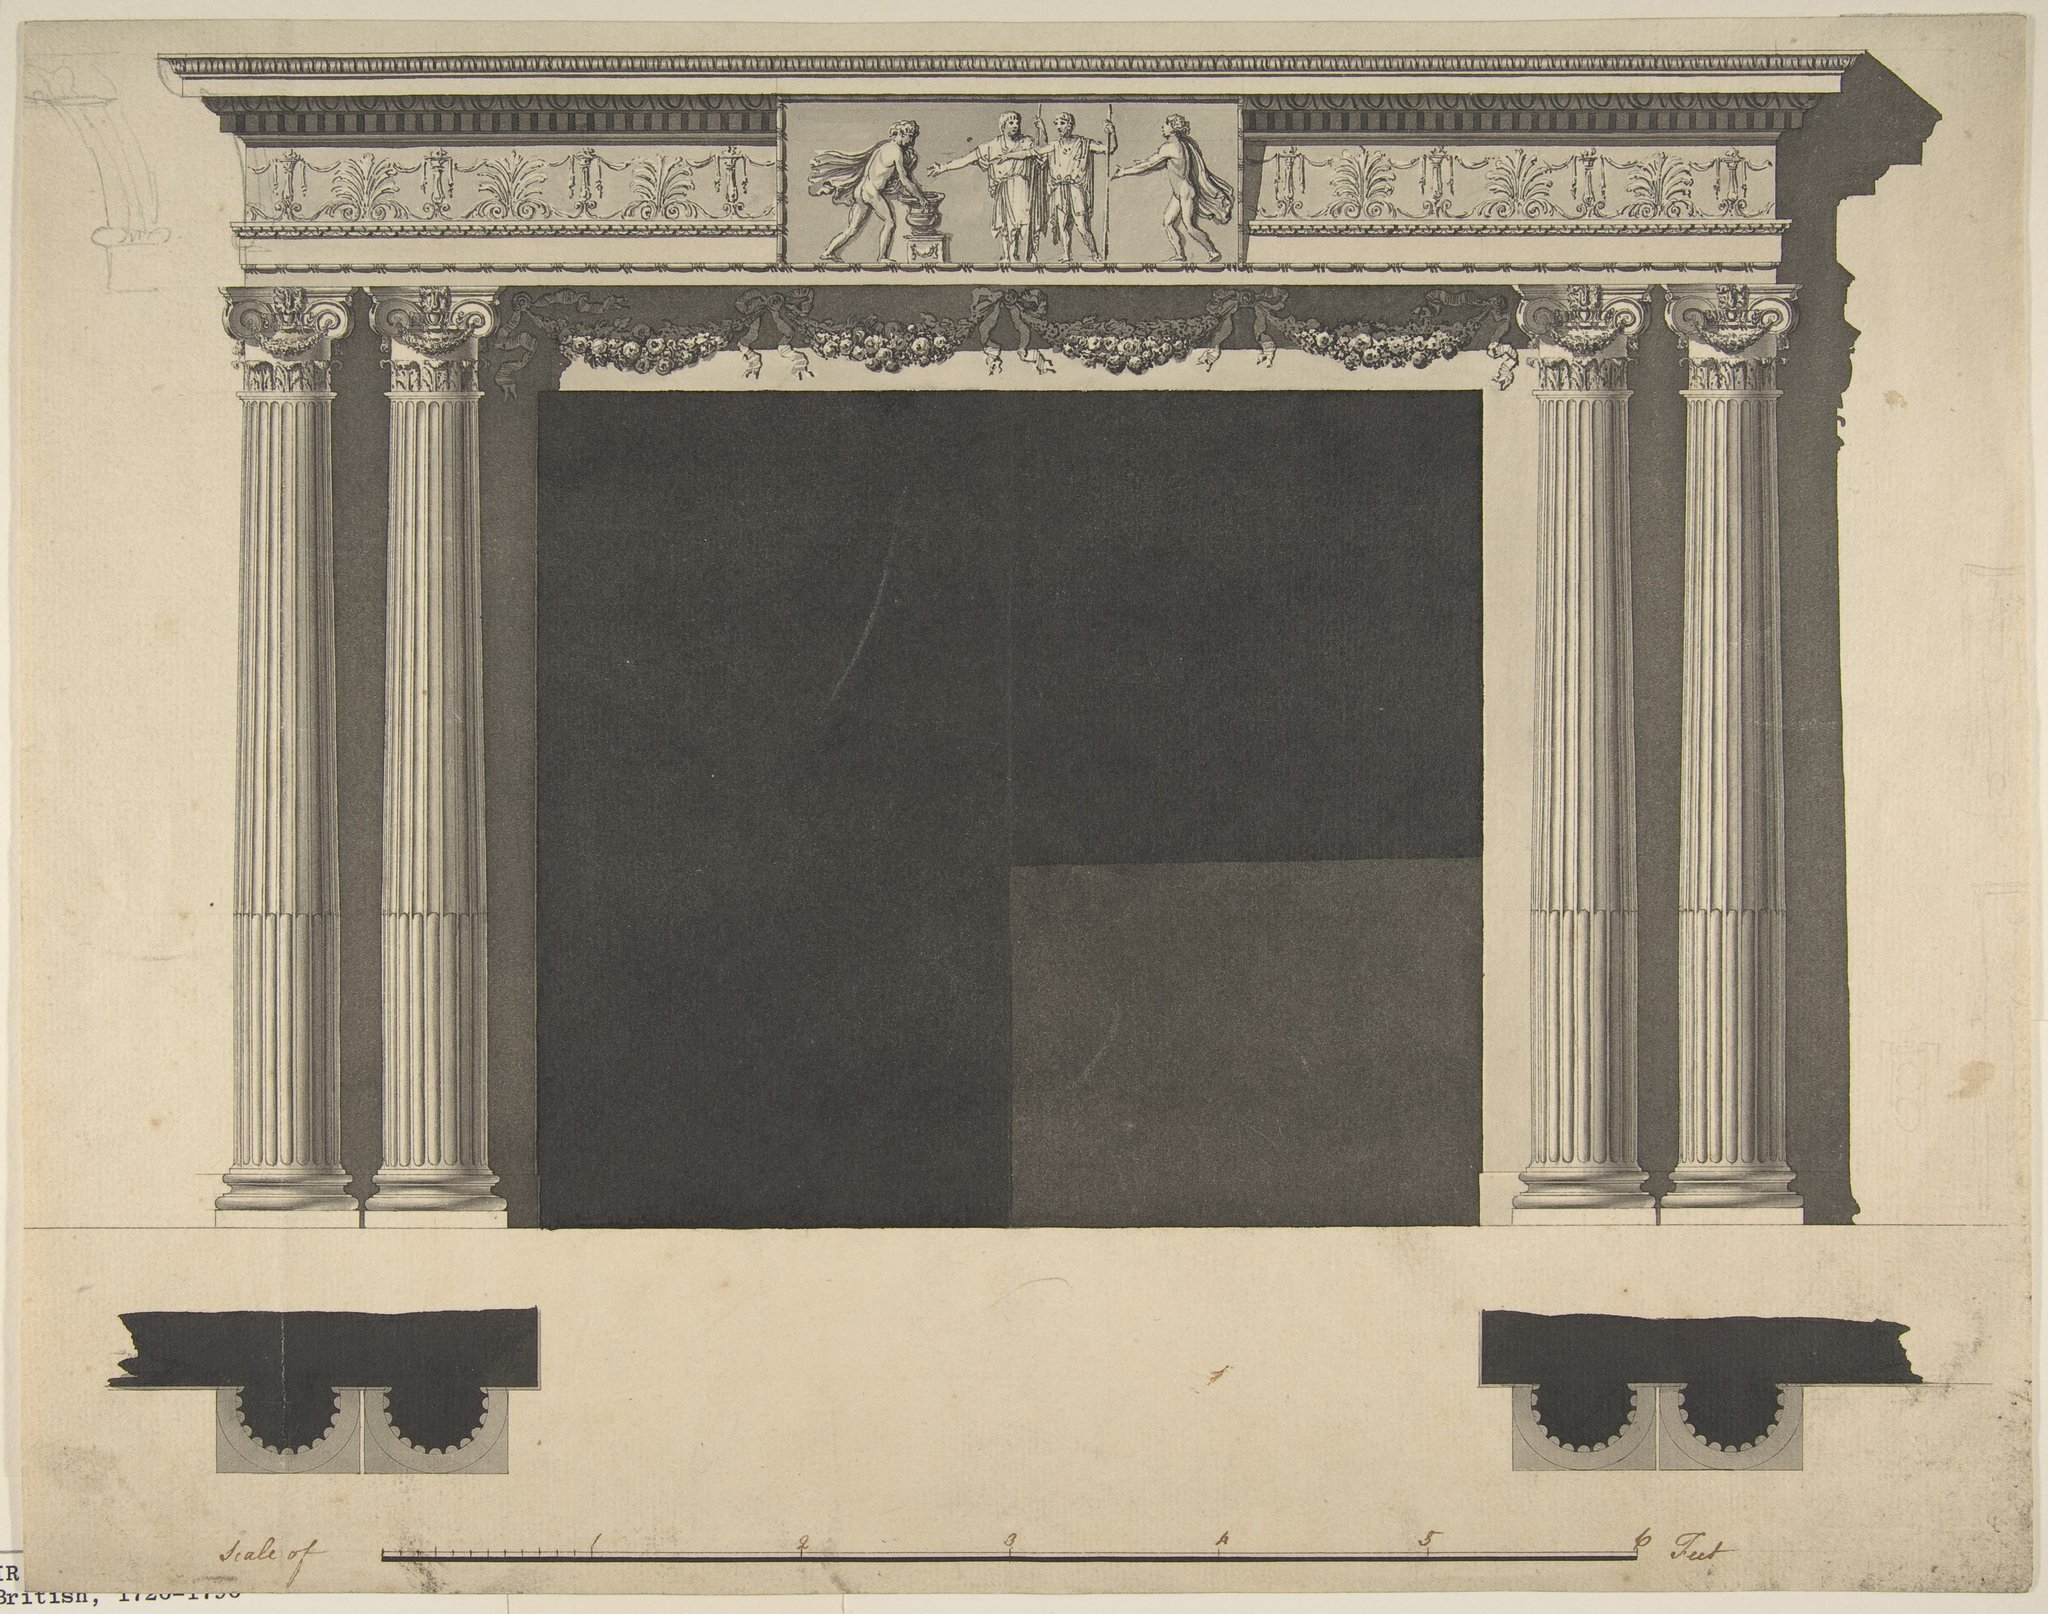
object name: drawing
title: Design for a Chimneypiece with Ionic columns, a Frieze, and Cornice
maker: sir william chambers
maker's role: artist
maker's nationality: british, born sweden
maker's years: 1723-1796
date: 1743-1796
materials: graphite, ink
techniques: brush, pen, wash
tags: architecture